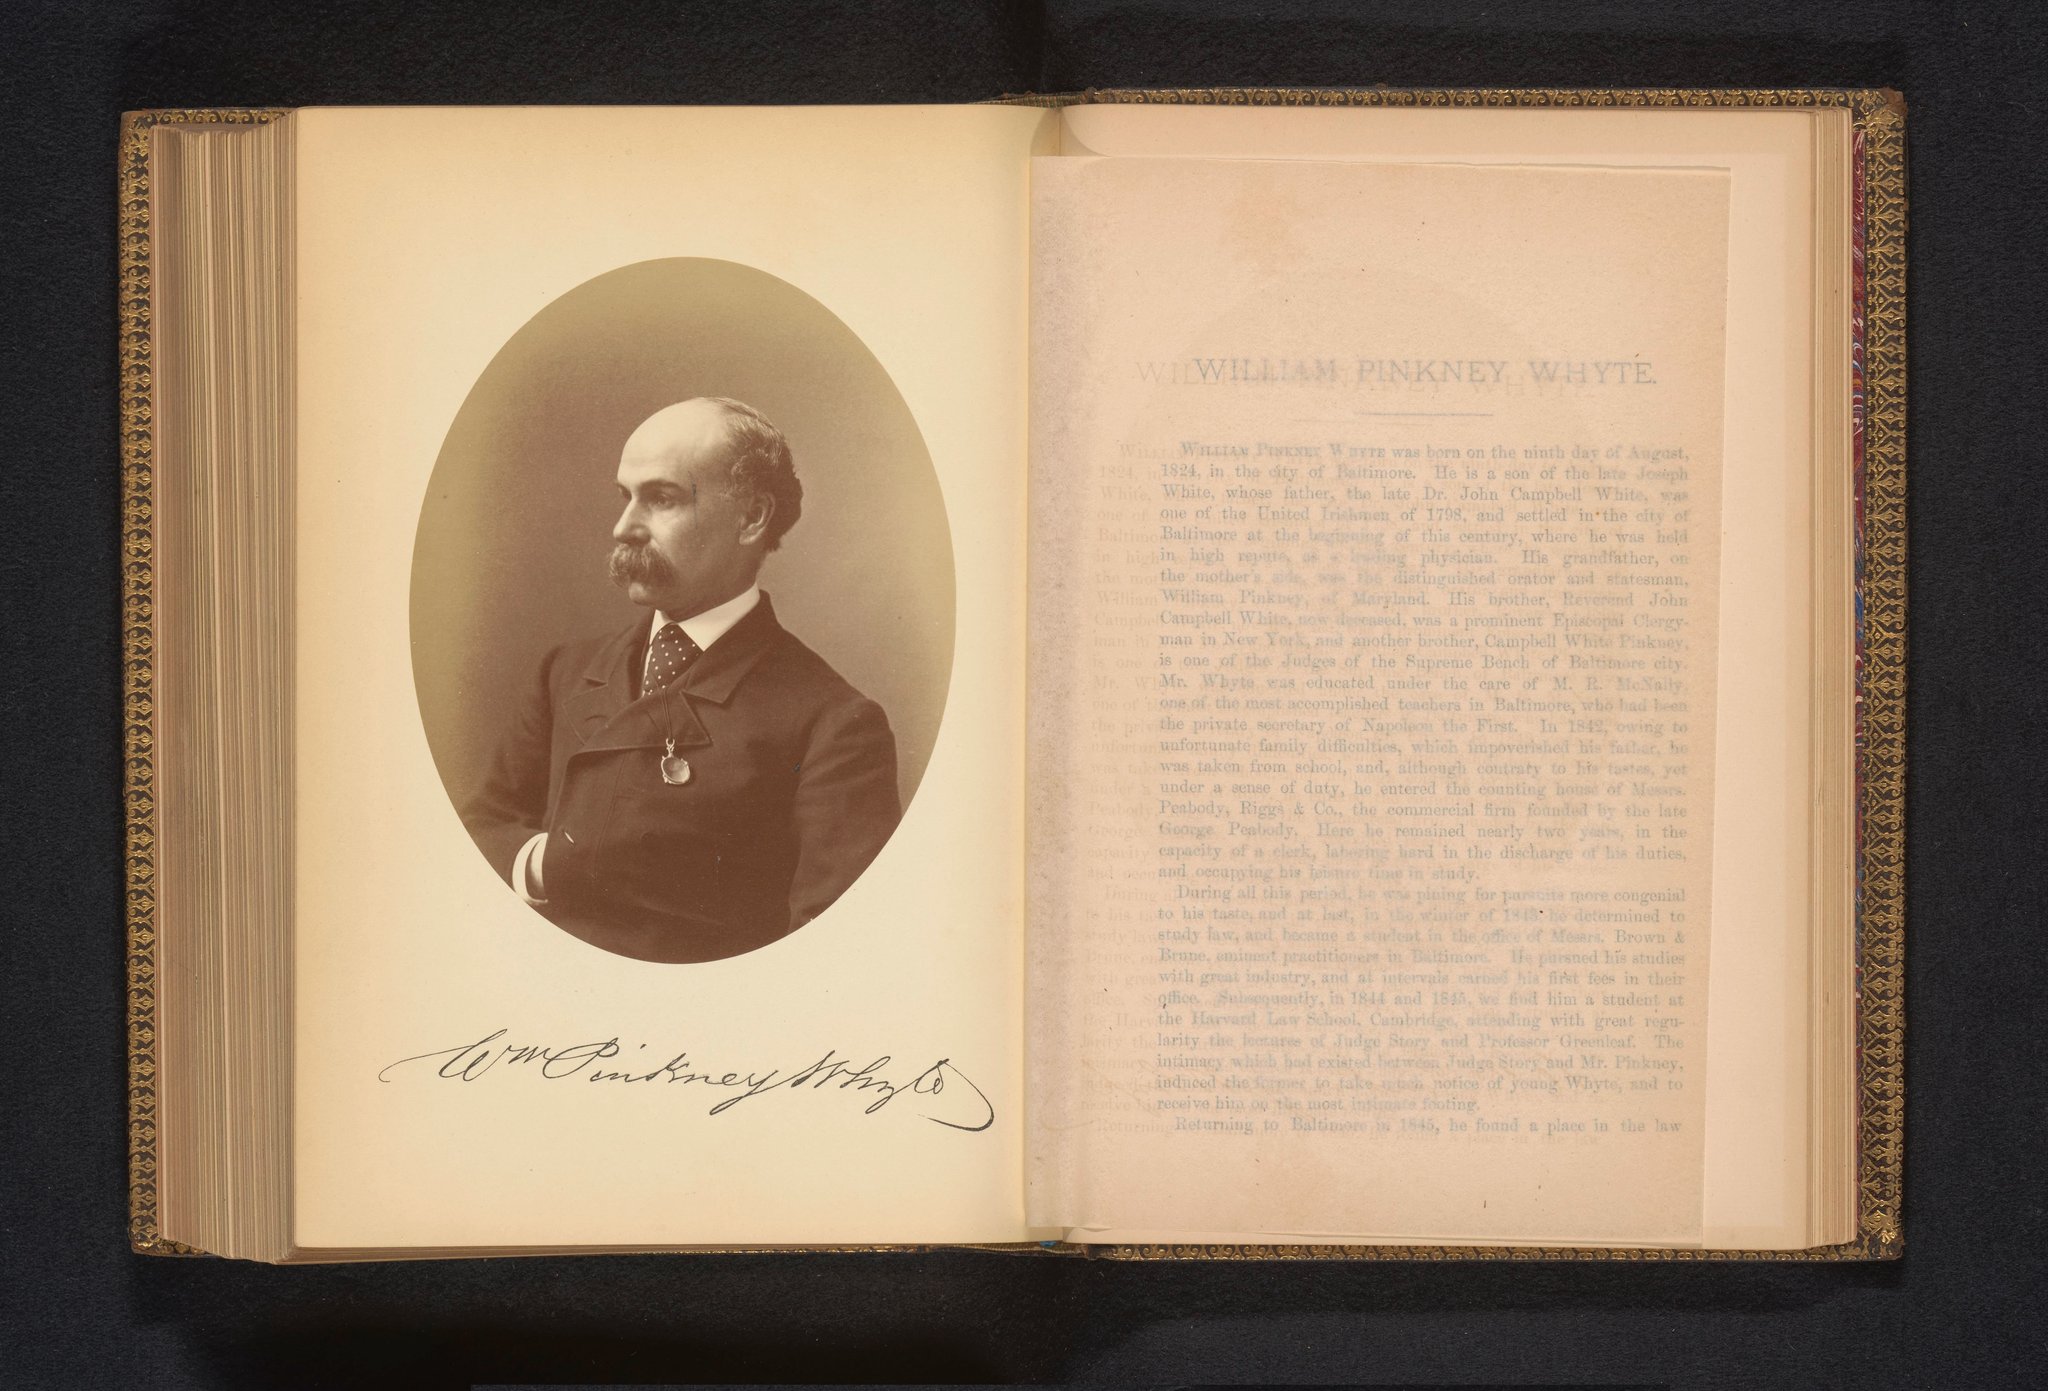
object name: photograph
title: Portret van William Pinkney Whyte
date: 1866-1871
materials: photographic support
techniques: albumen print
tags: politician, historical persons